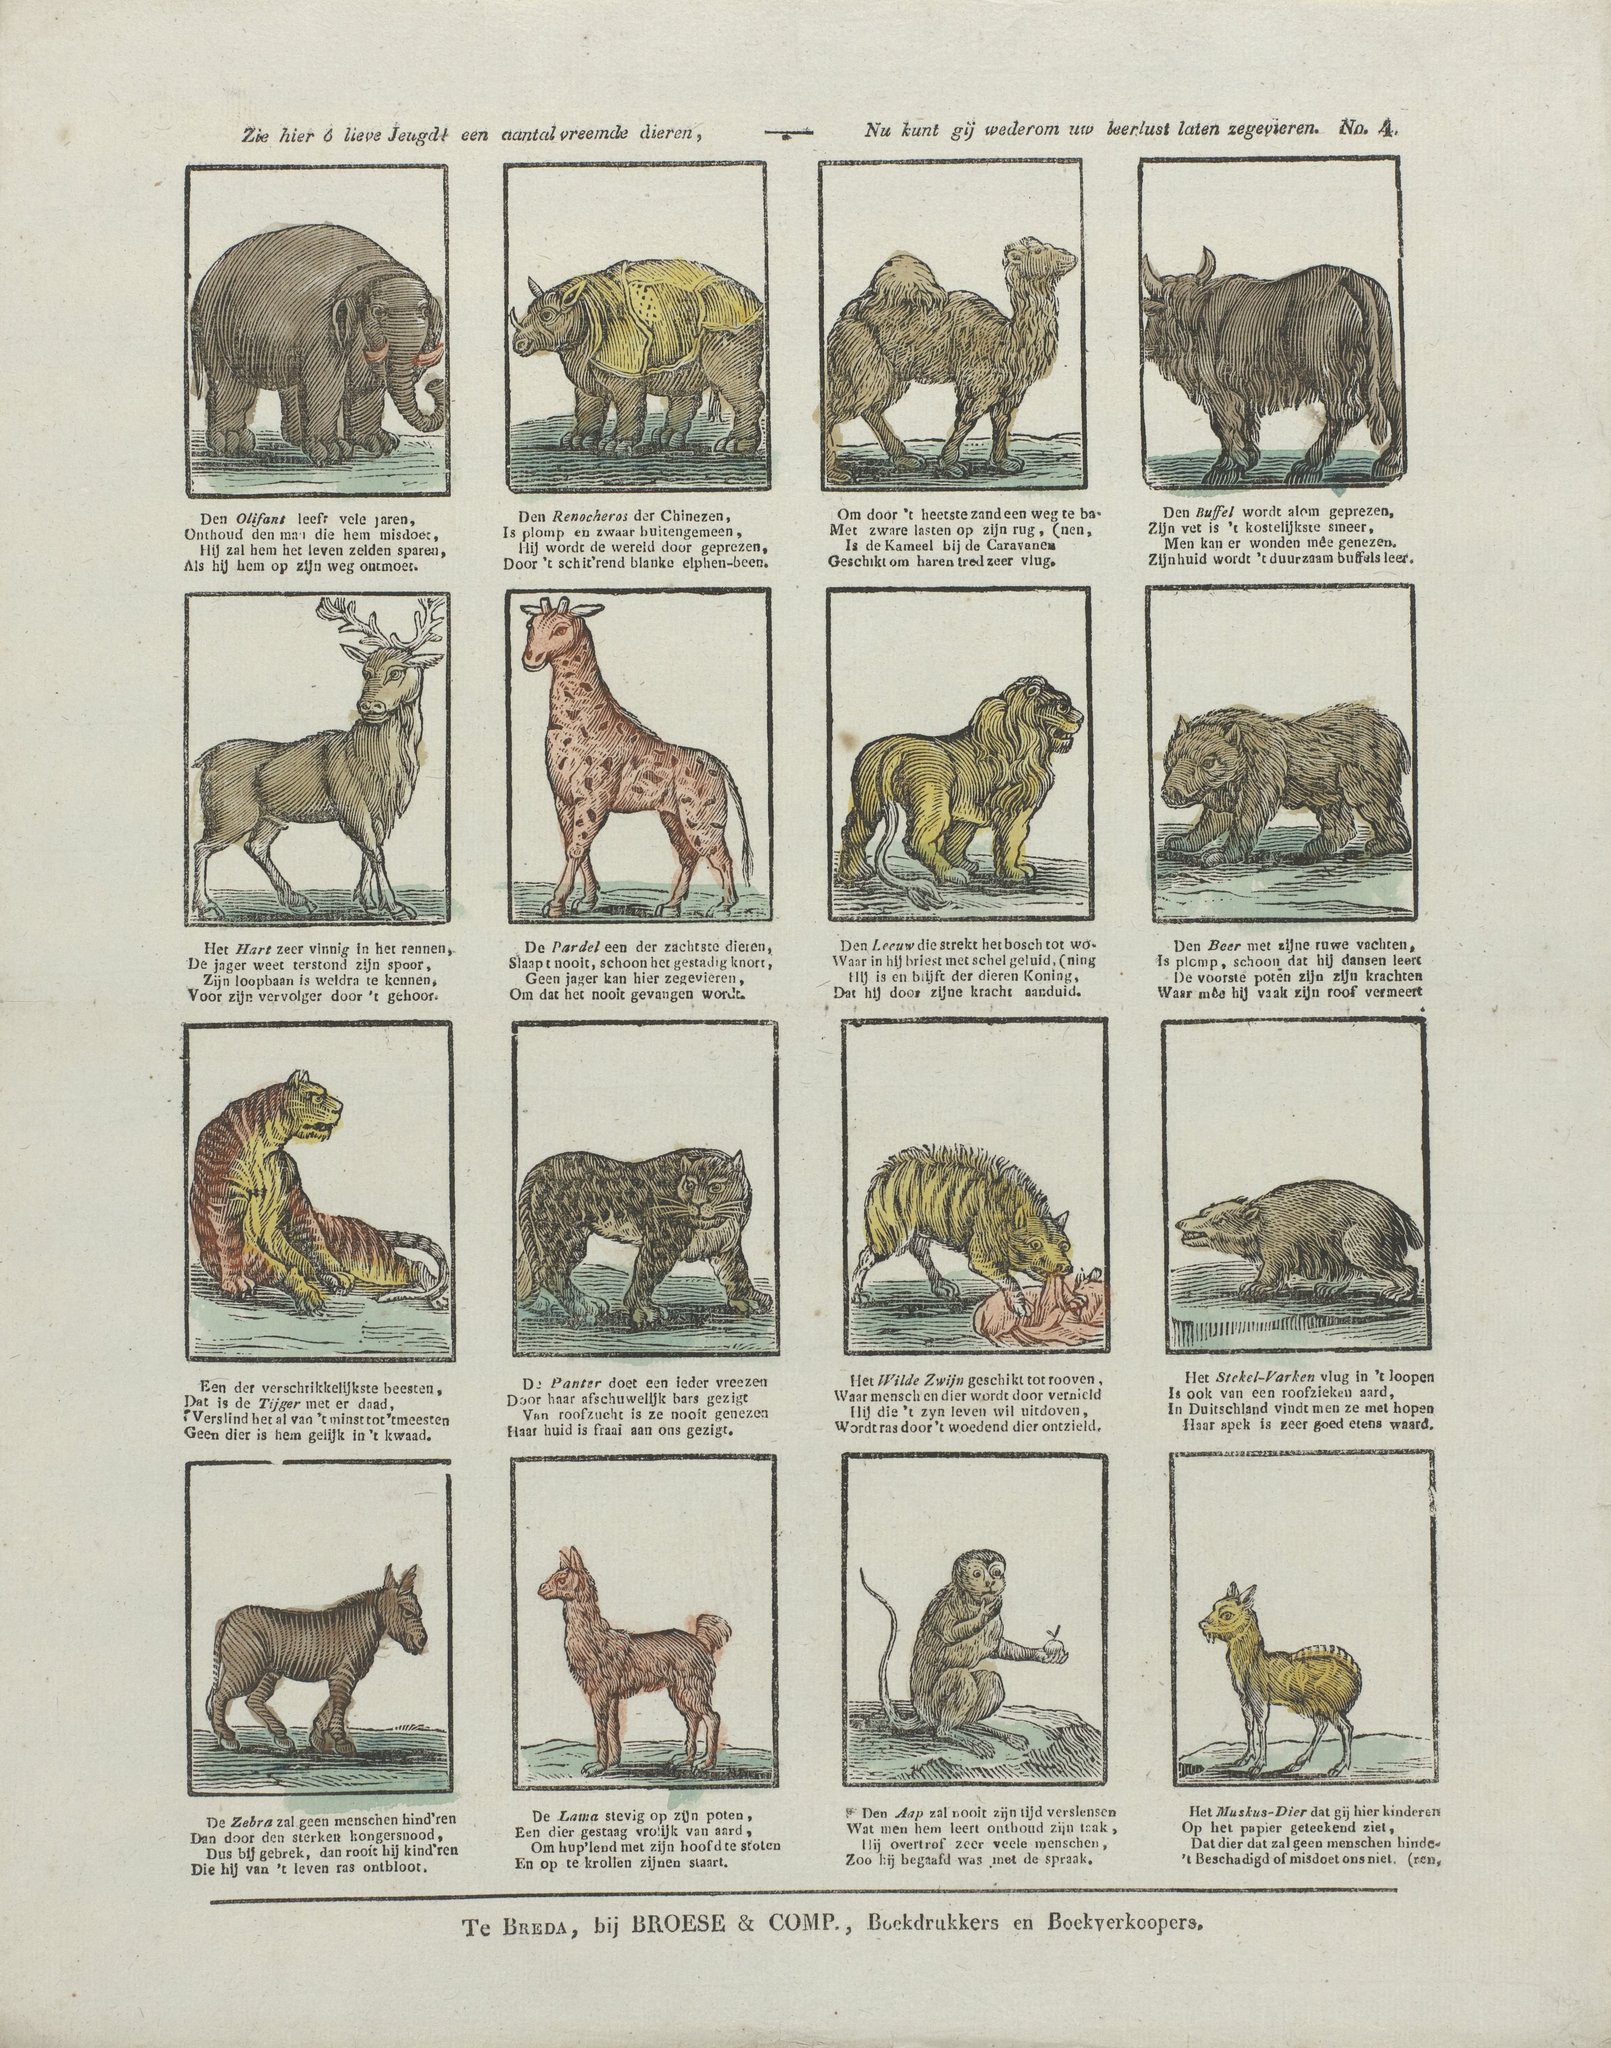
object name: print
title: Zie hier ô lieve jeugd! een aantal vreemde dieren, - Nu kunt gij wederom uw leerlust laten zegevieren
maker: Anonymous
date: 1828-1853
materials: paper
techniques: colour, letterpress printing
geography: breda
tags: hoofed animals: camel, monkeys, apes, hoofed animals: rhinoceros, hoofed animals: giraffe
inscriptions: collector's mark: Lugt 2760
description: Blad met 16 voorstellingen van wilde dieren, zoals een neushoorn, een kameel, een giraf en een aap. Onder elke voorstelling een vierregelig vers. Genummerd rechtsboven: No. 4.